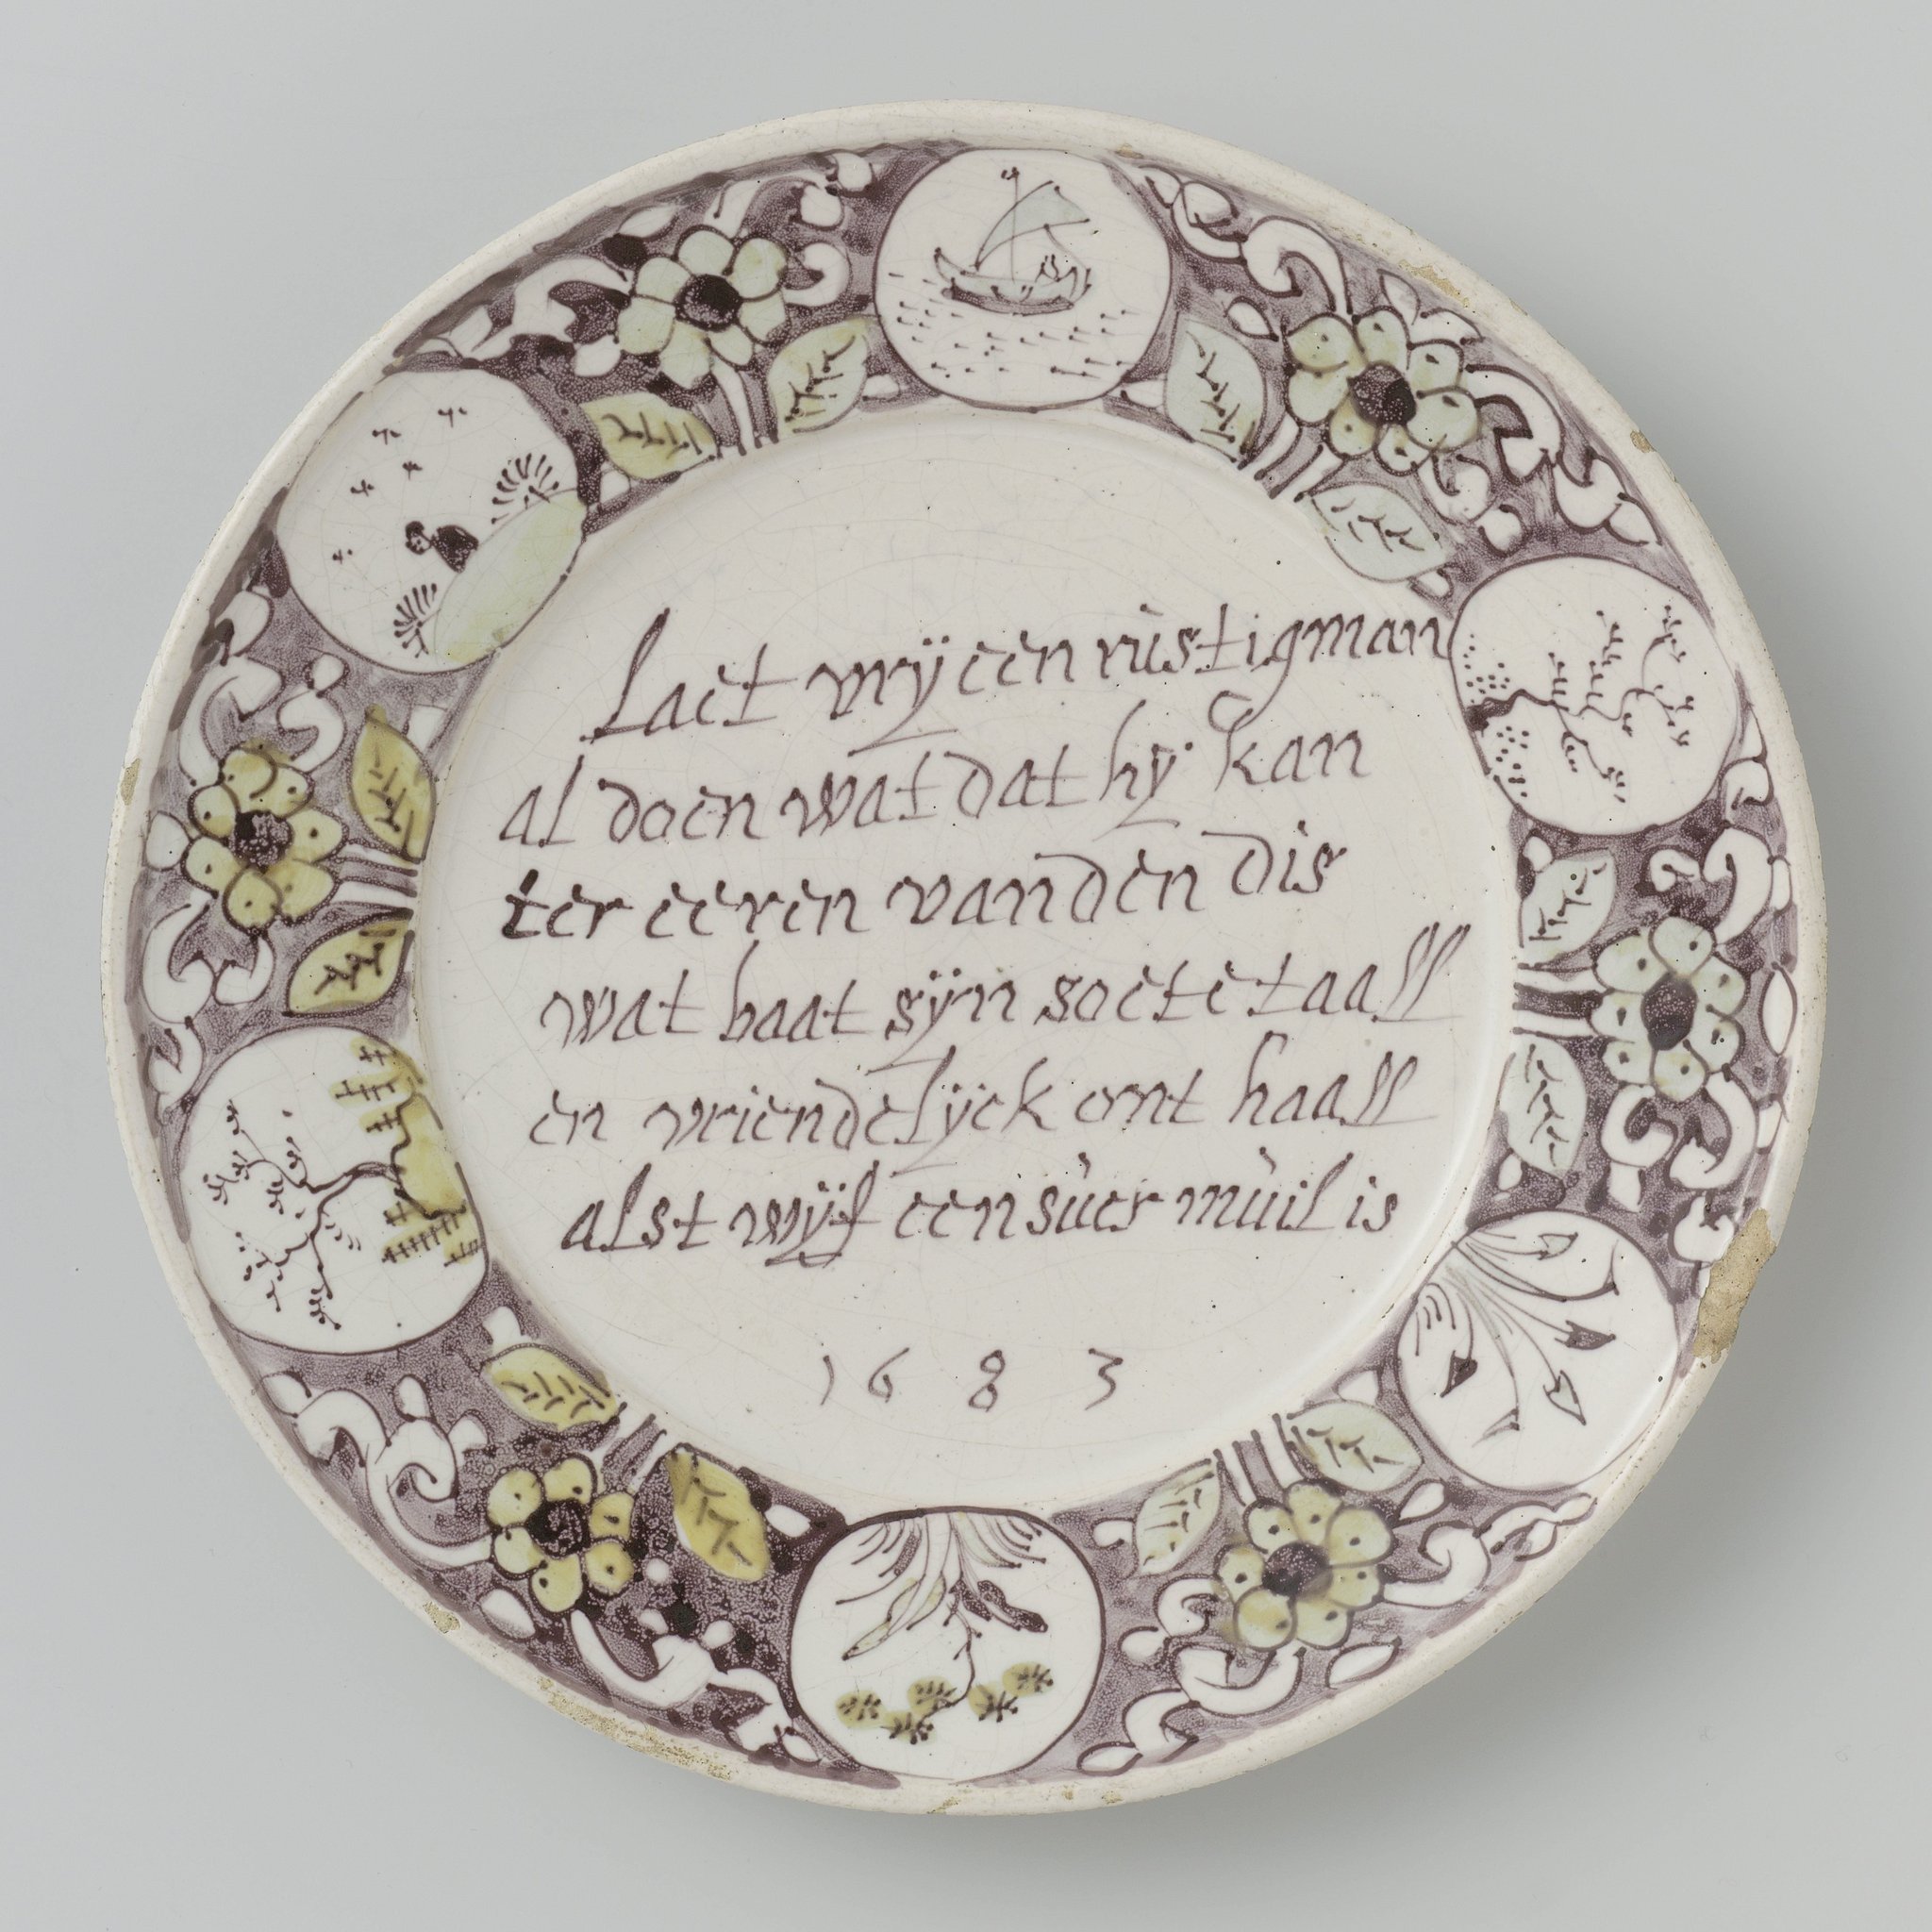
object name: plate dish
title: Bord met het opschrift: Laet vrij een rustig man/ al doen wat dat hij kan/ ter eeren dan den dis/ wat baat sijn soete taall/ en vriendelijk ont haall/ alst wijff een suer muil is/ 1683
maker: Anonymous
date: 1683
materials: earthenware, glaze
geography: delft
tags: ornaments ~ art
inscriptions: inscription: ‘Laet vrij een rustig man/ al doen wat dat hij kan/ ter eeren dan den dis/ wat baat sijn soete taall/ en vriendelijk ont haall/ alst wijff een suer muil is’, date: ‘1683’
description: Bord van faience. Veelkleurig beschilderd met een tekst. Laet vrij een rustig man/ al doen wat dat hij kan/ ter eeren dan den dis/ wat baat sijn soete taall/ en vriendelijk ont haall/ alst wijff een suer muil is/ 1683